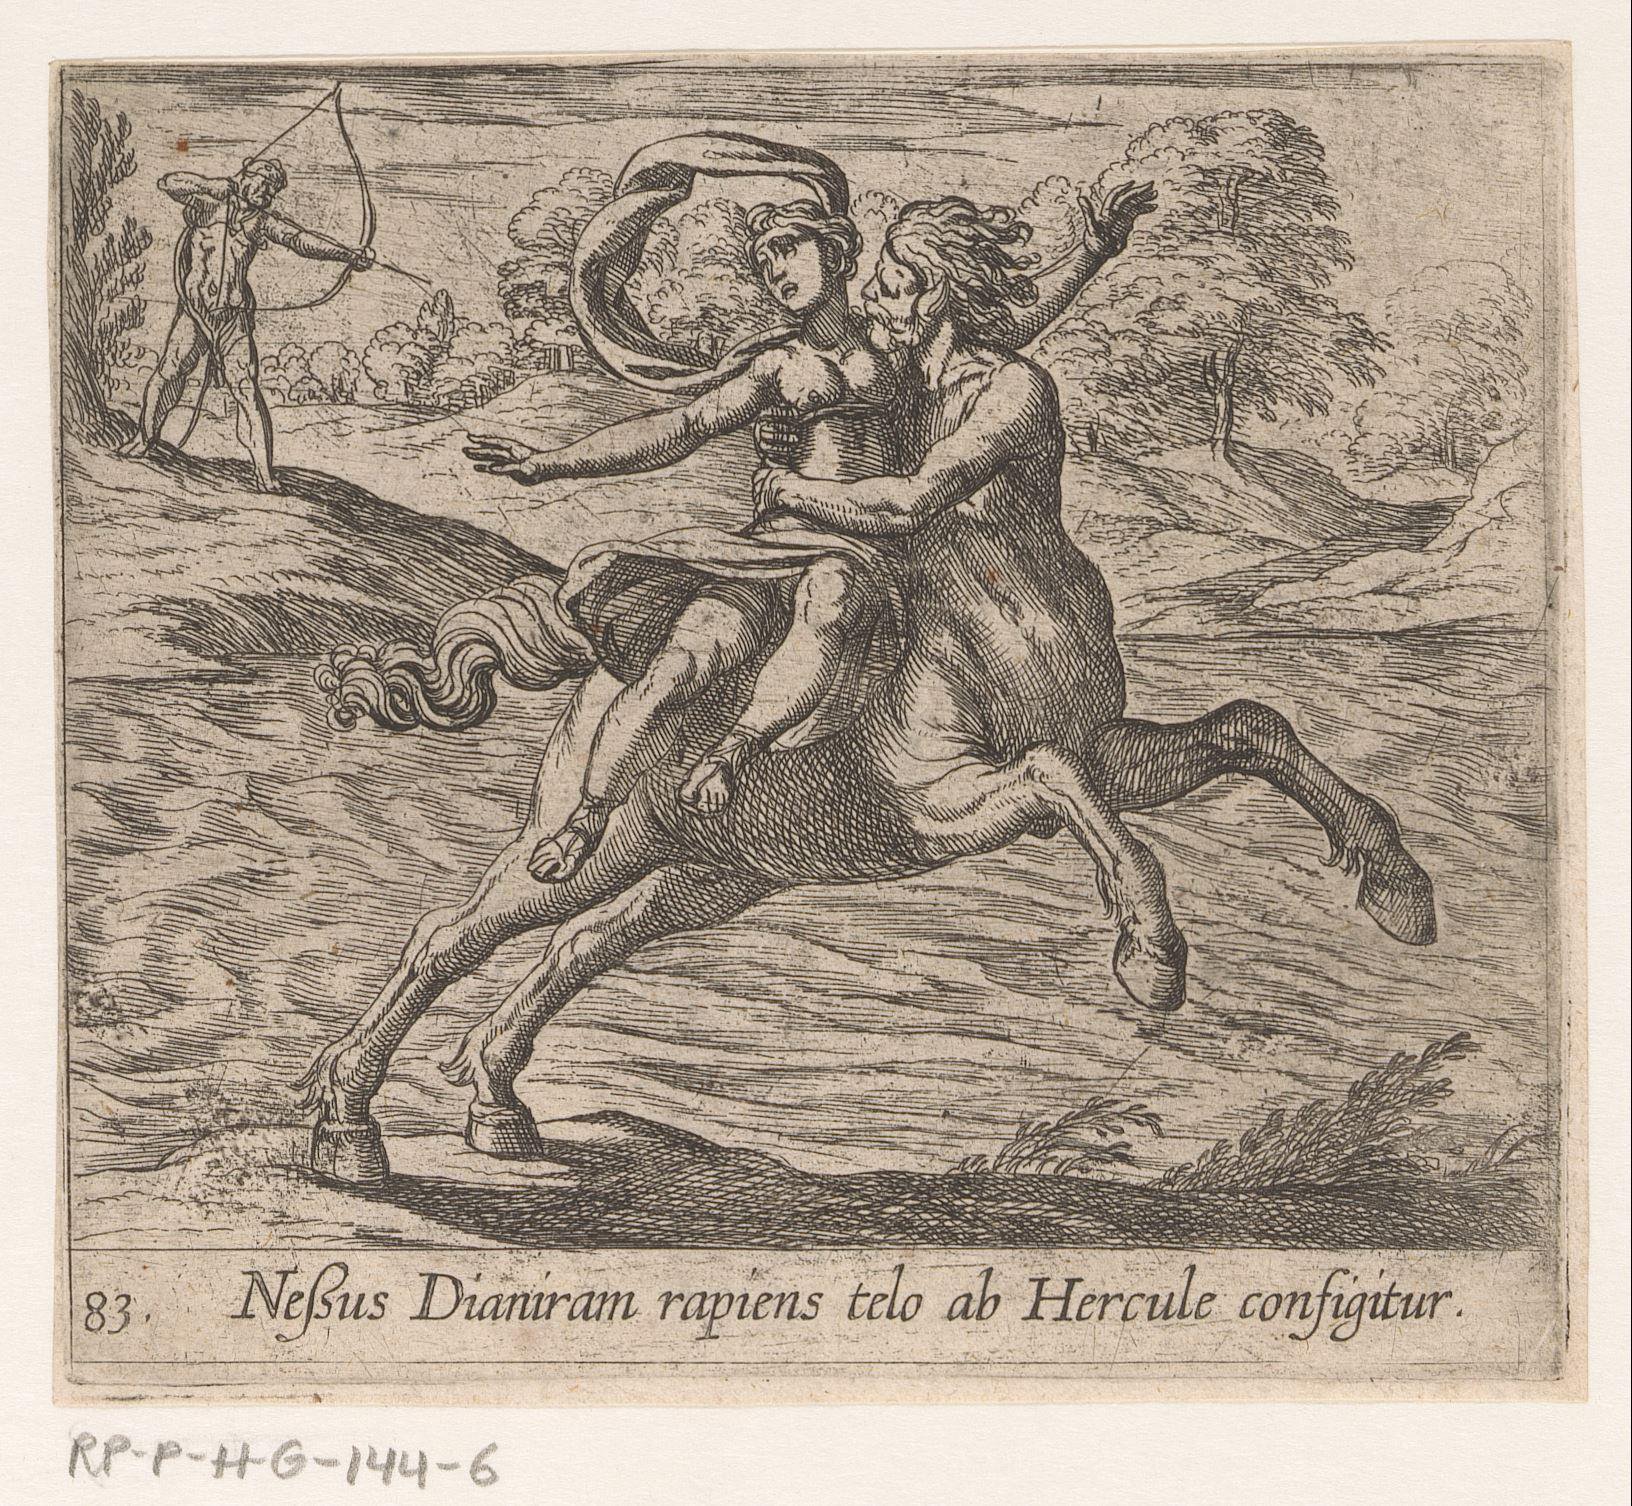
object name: print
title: Hercules doodt de centaur Nessus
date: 1606-1638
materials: paper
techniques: etching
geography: amsterdam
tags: hercules shoots nessus, the centaur, who attempts to carry off deianira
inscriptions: collector's mark: ‘Hinloopen’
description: De centaur Nessus is veerman bij een rivier. Als hij Deïanira overzet, probeert hij haar te roven en galoppeert hij met haar weg. Hercules die al op de andere oever stond, spant zijn boog om Nessus neer te schieten. Titel in het Latijn in ondermarge.